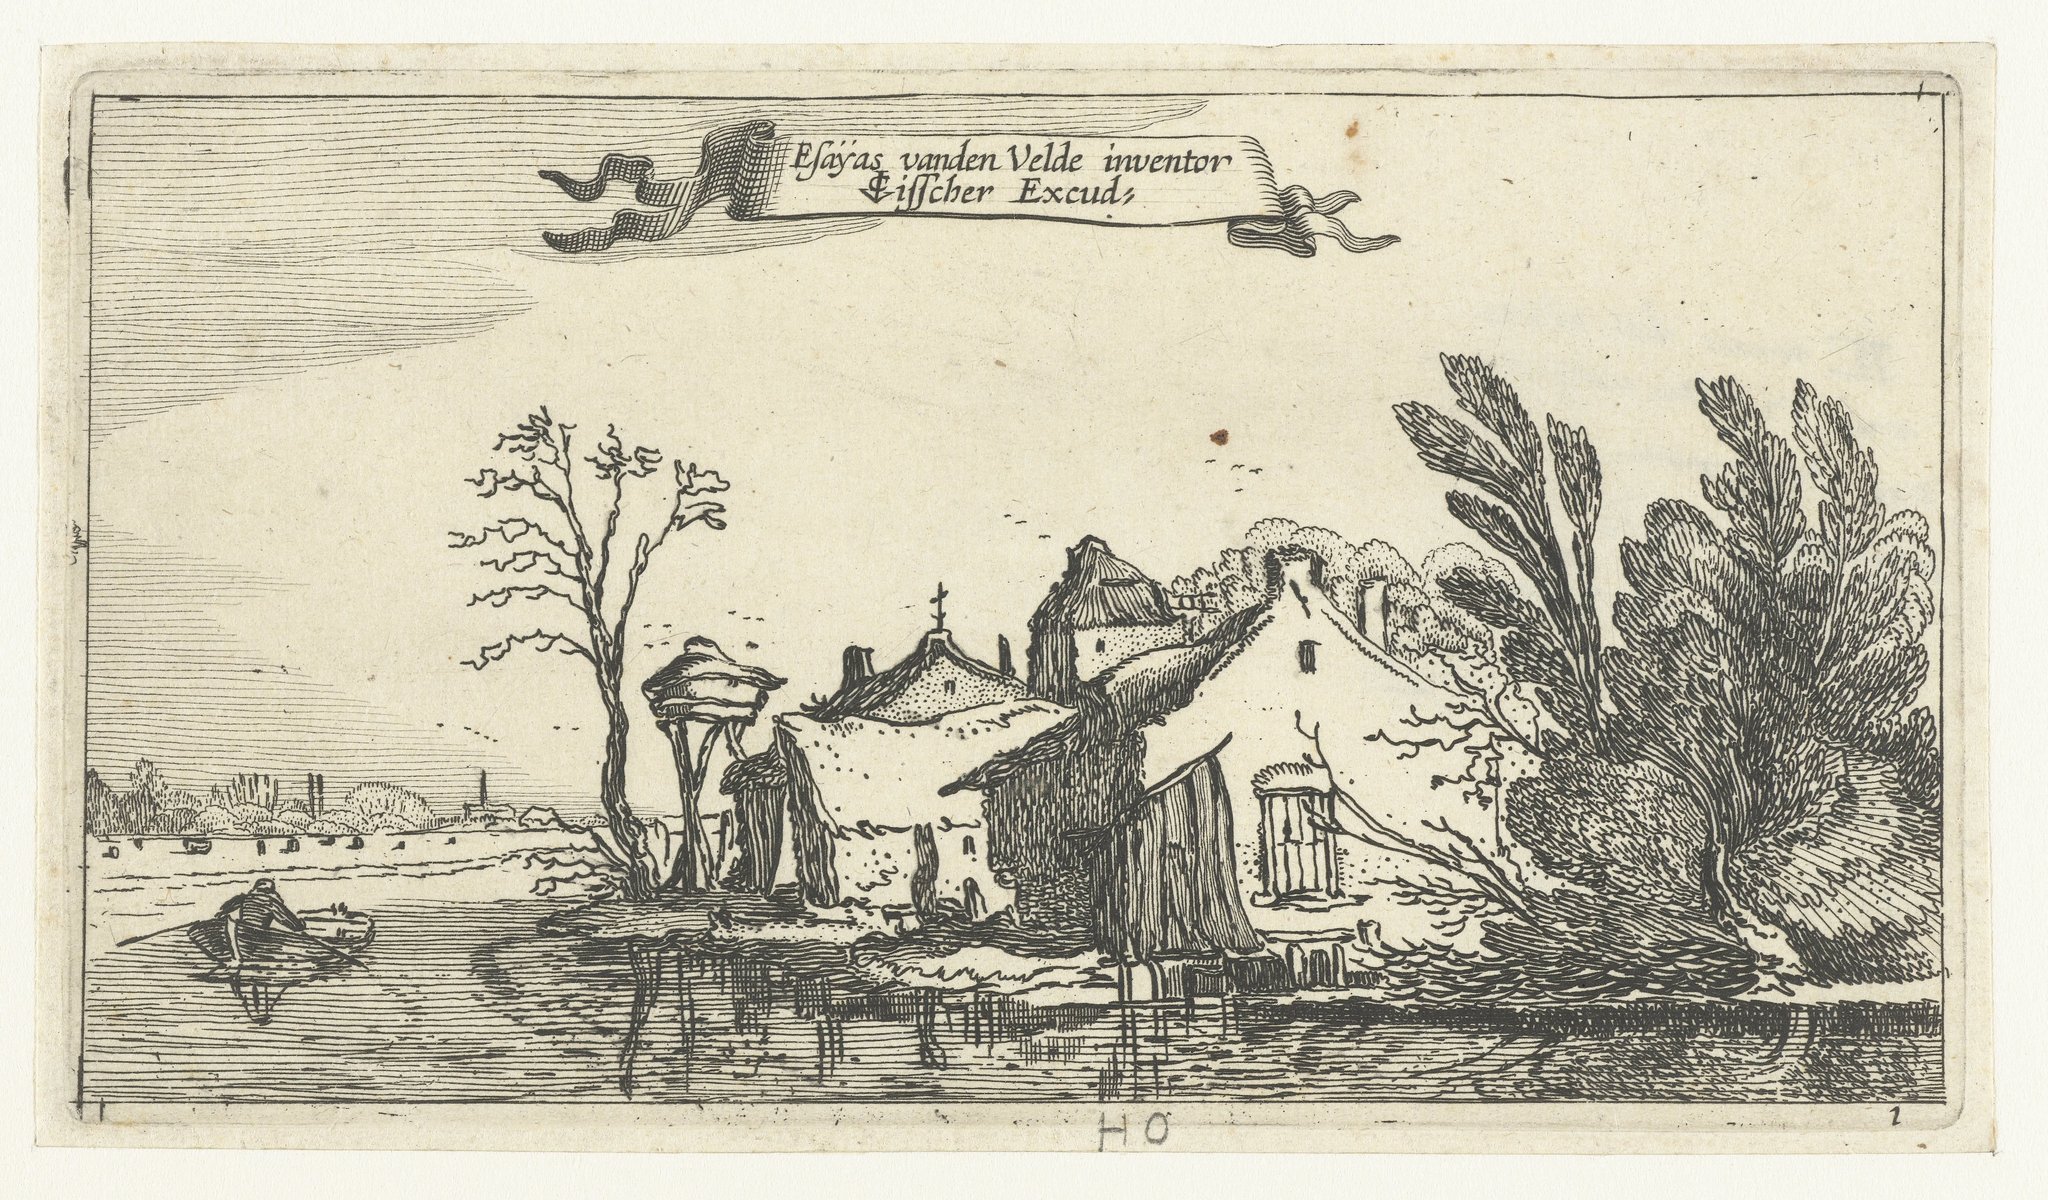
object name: print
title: Landschappen naar Esaias van de Velde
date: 1610-1650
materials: paper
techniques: engraving, etching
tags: farm or solitary house in landscape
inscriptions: collector's mark: Lugt 2228a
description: Tekening van Esaias van de Velde in Darmstadt, zie Keyes 1984, cat.nr. D 105, pl. 15